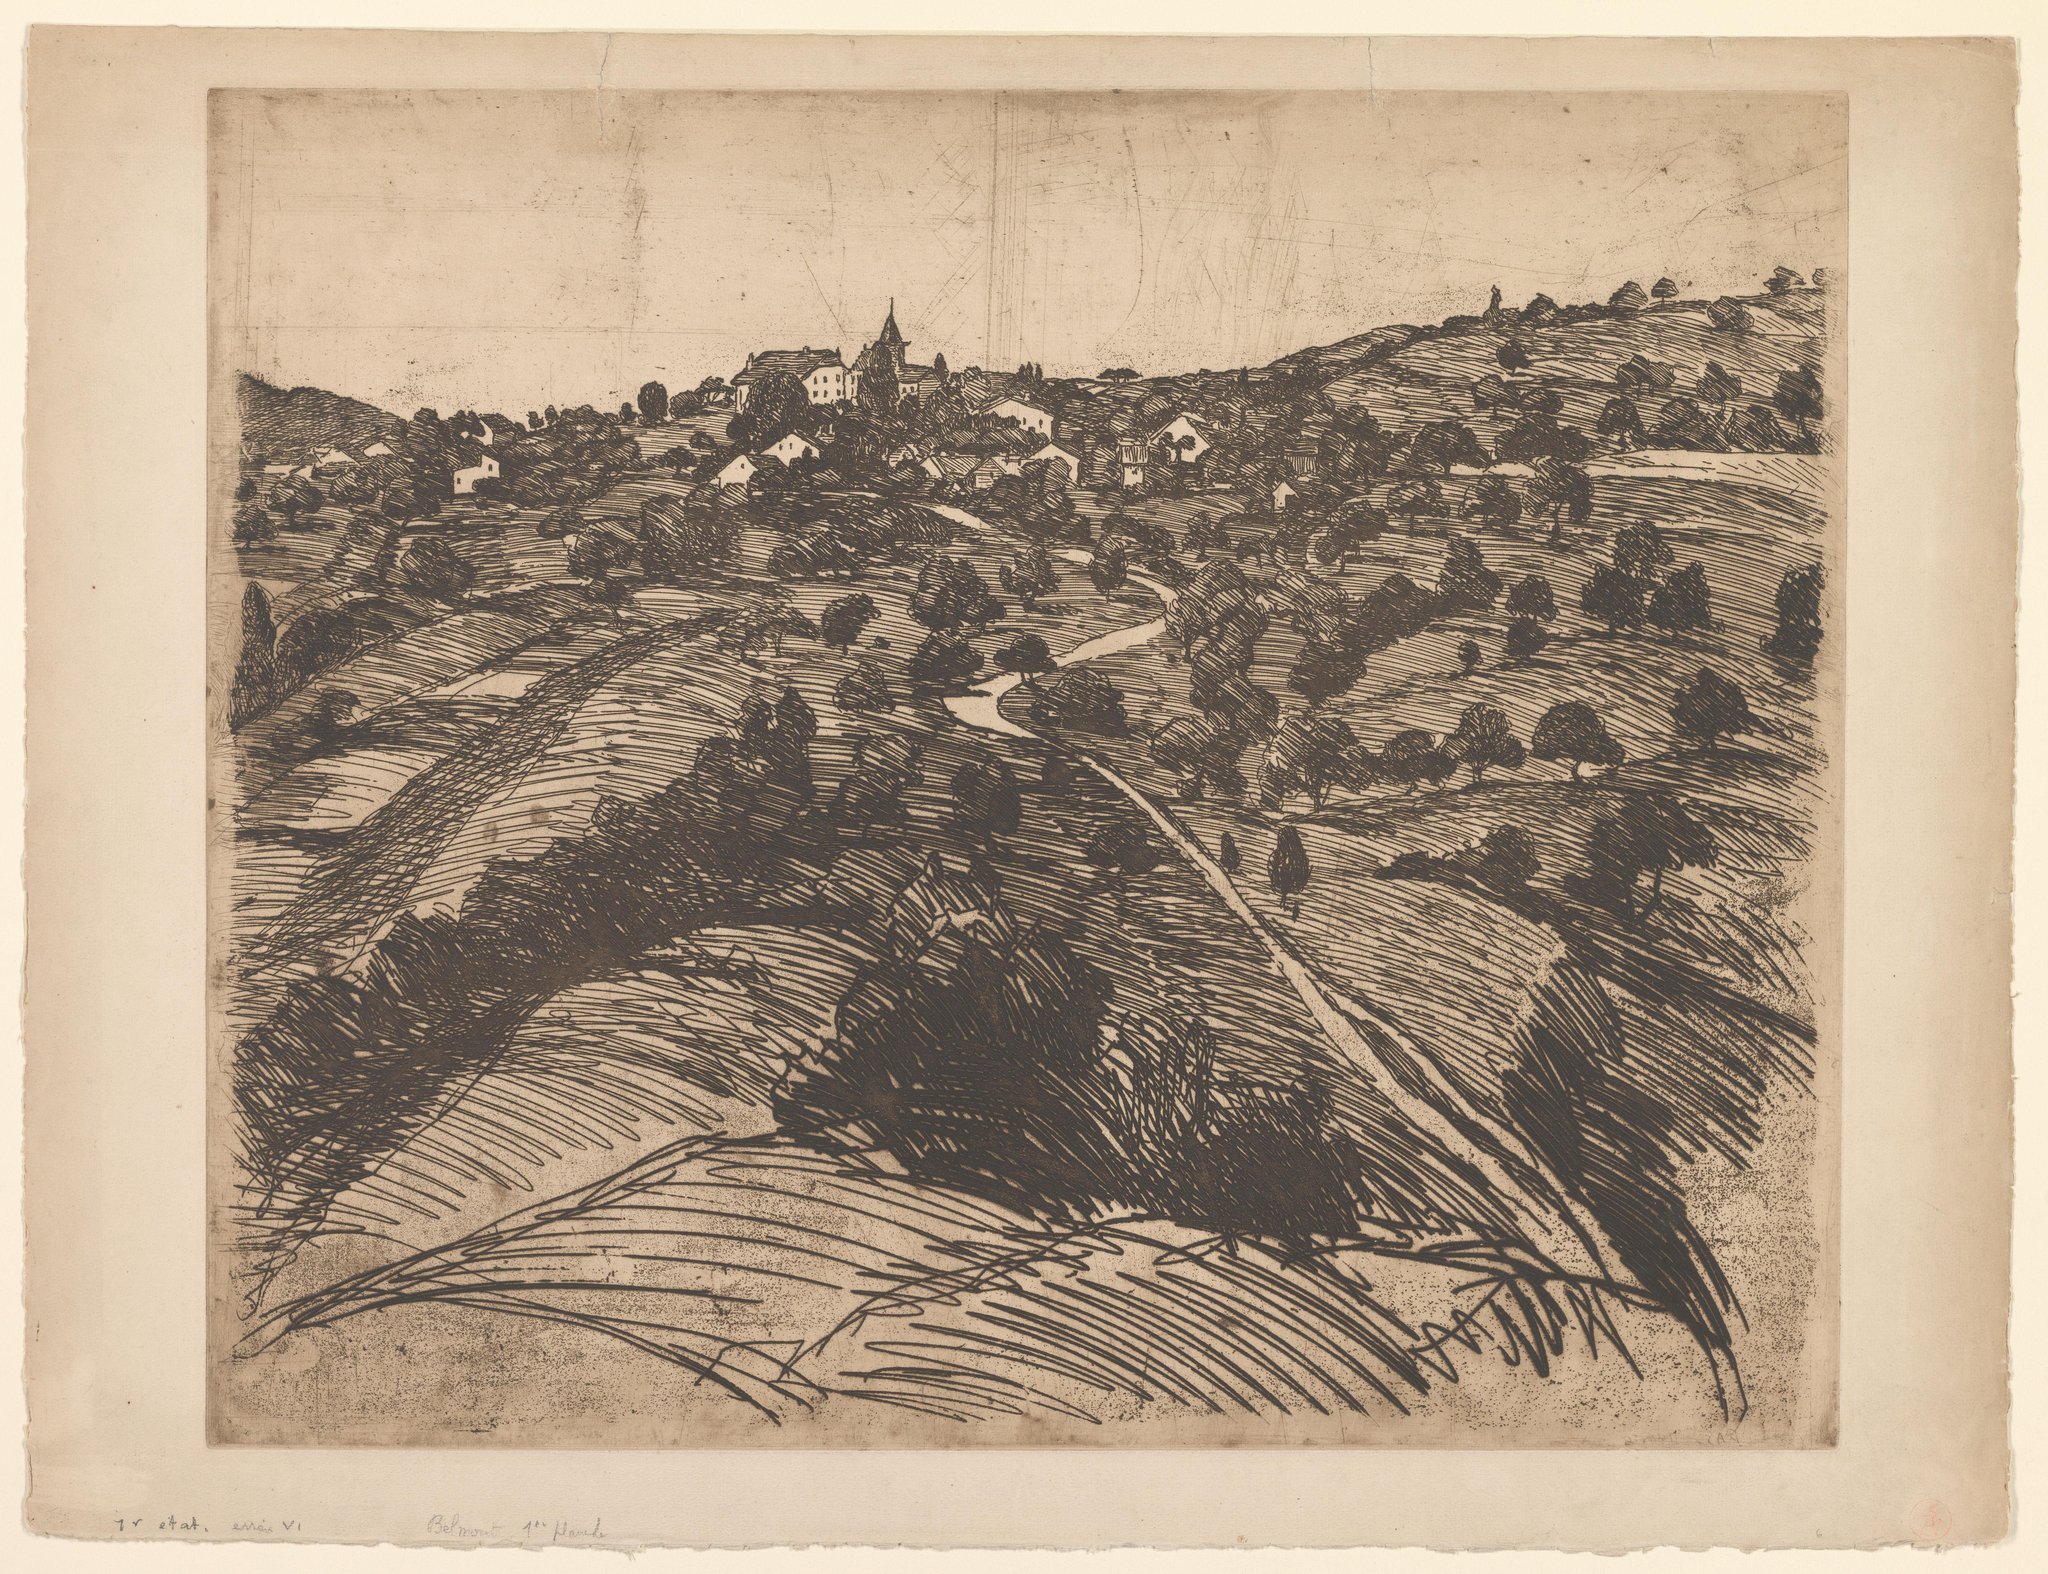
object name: print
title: Le Coteau (Belmont)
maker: théophile alexandre steinlen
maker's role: draughtsman, painter, print maker, sculptor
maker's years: 1859-1923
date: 1914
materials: paper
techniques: aquatint, drypoint, etching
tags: landscapes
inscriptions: annotation: ‘1er état, essai VI. Belmont 1er planche’, collector's mark: Lugt 2228